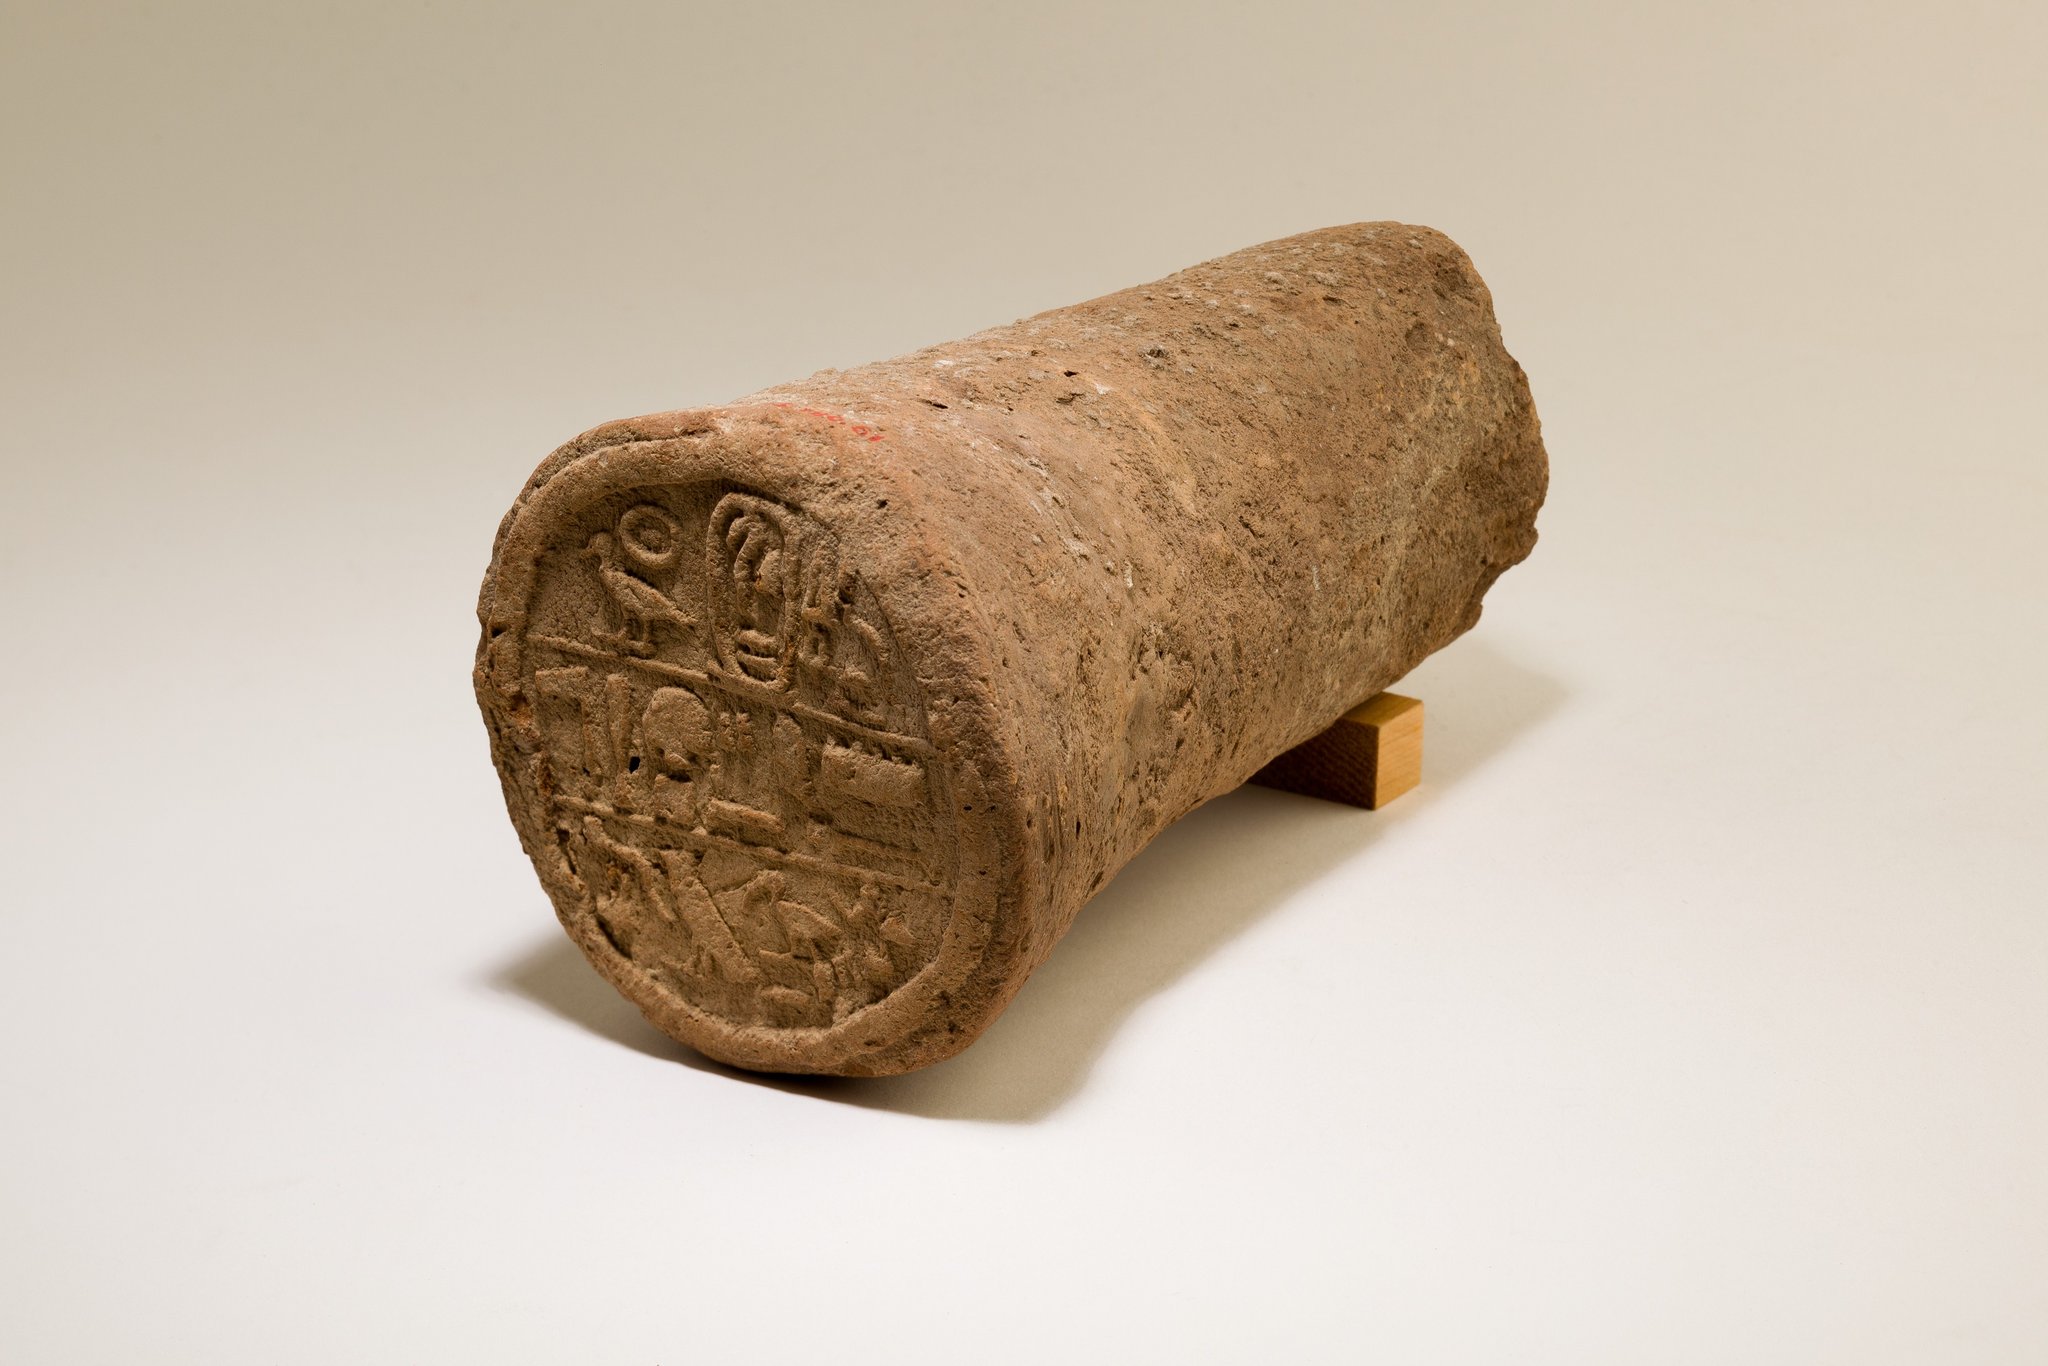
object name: cone, curcular impression, djehuty, first prophet of amun, seal bearer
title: Funerary Cone of First Prophet of Amun Djehuty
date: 1550-1525 BCE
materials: pottery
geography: egypt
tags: hieroglyphs